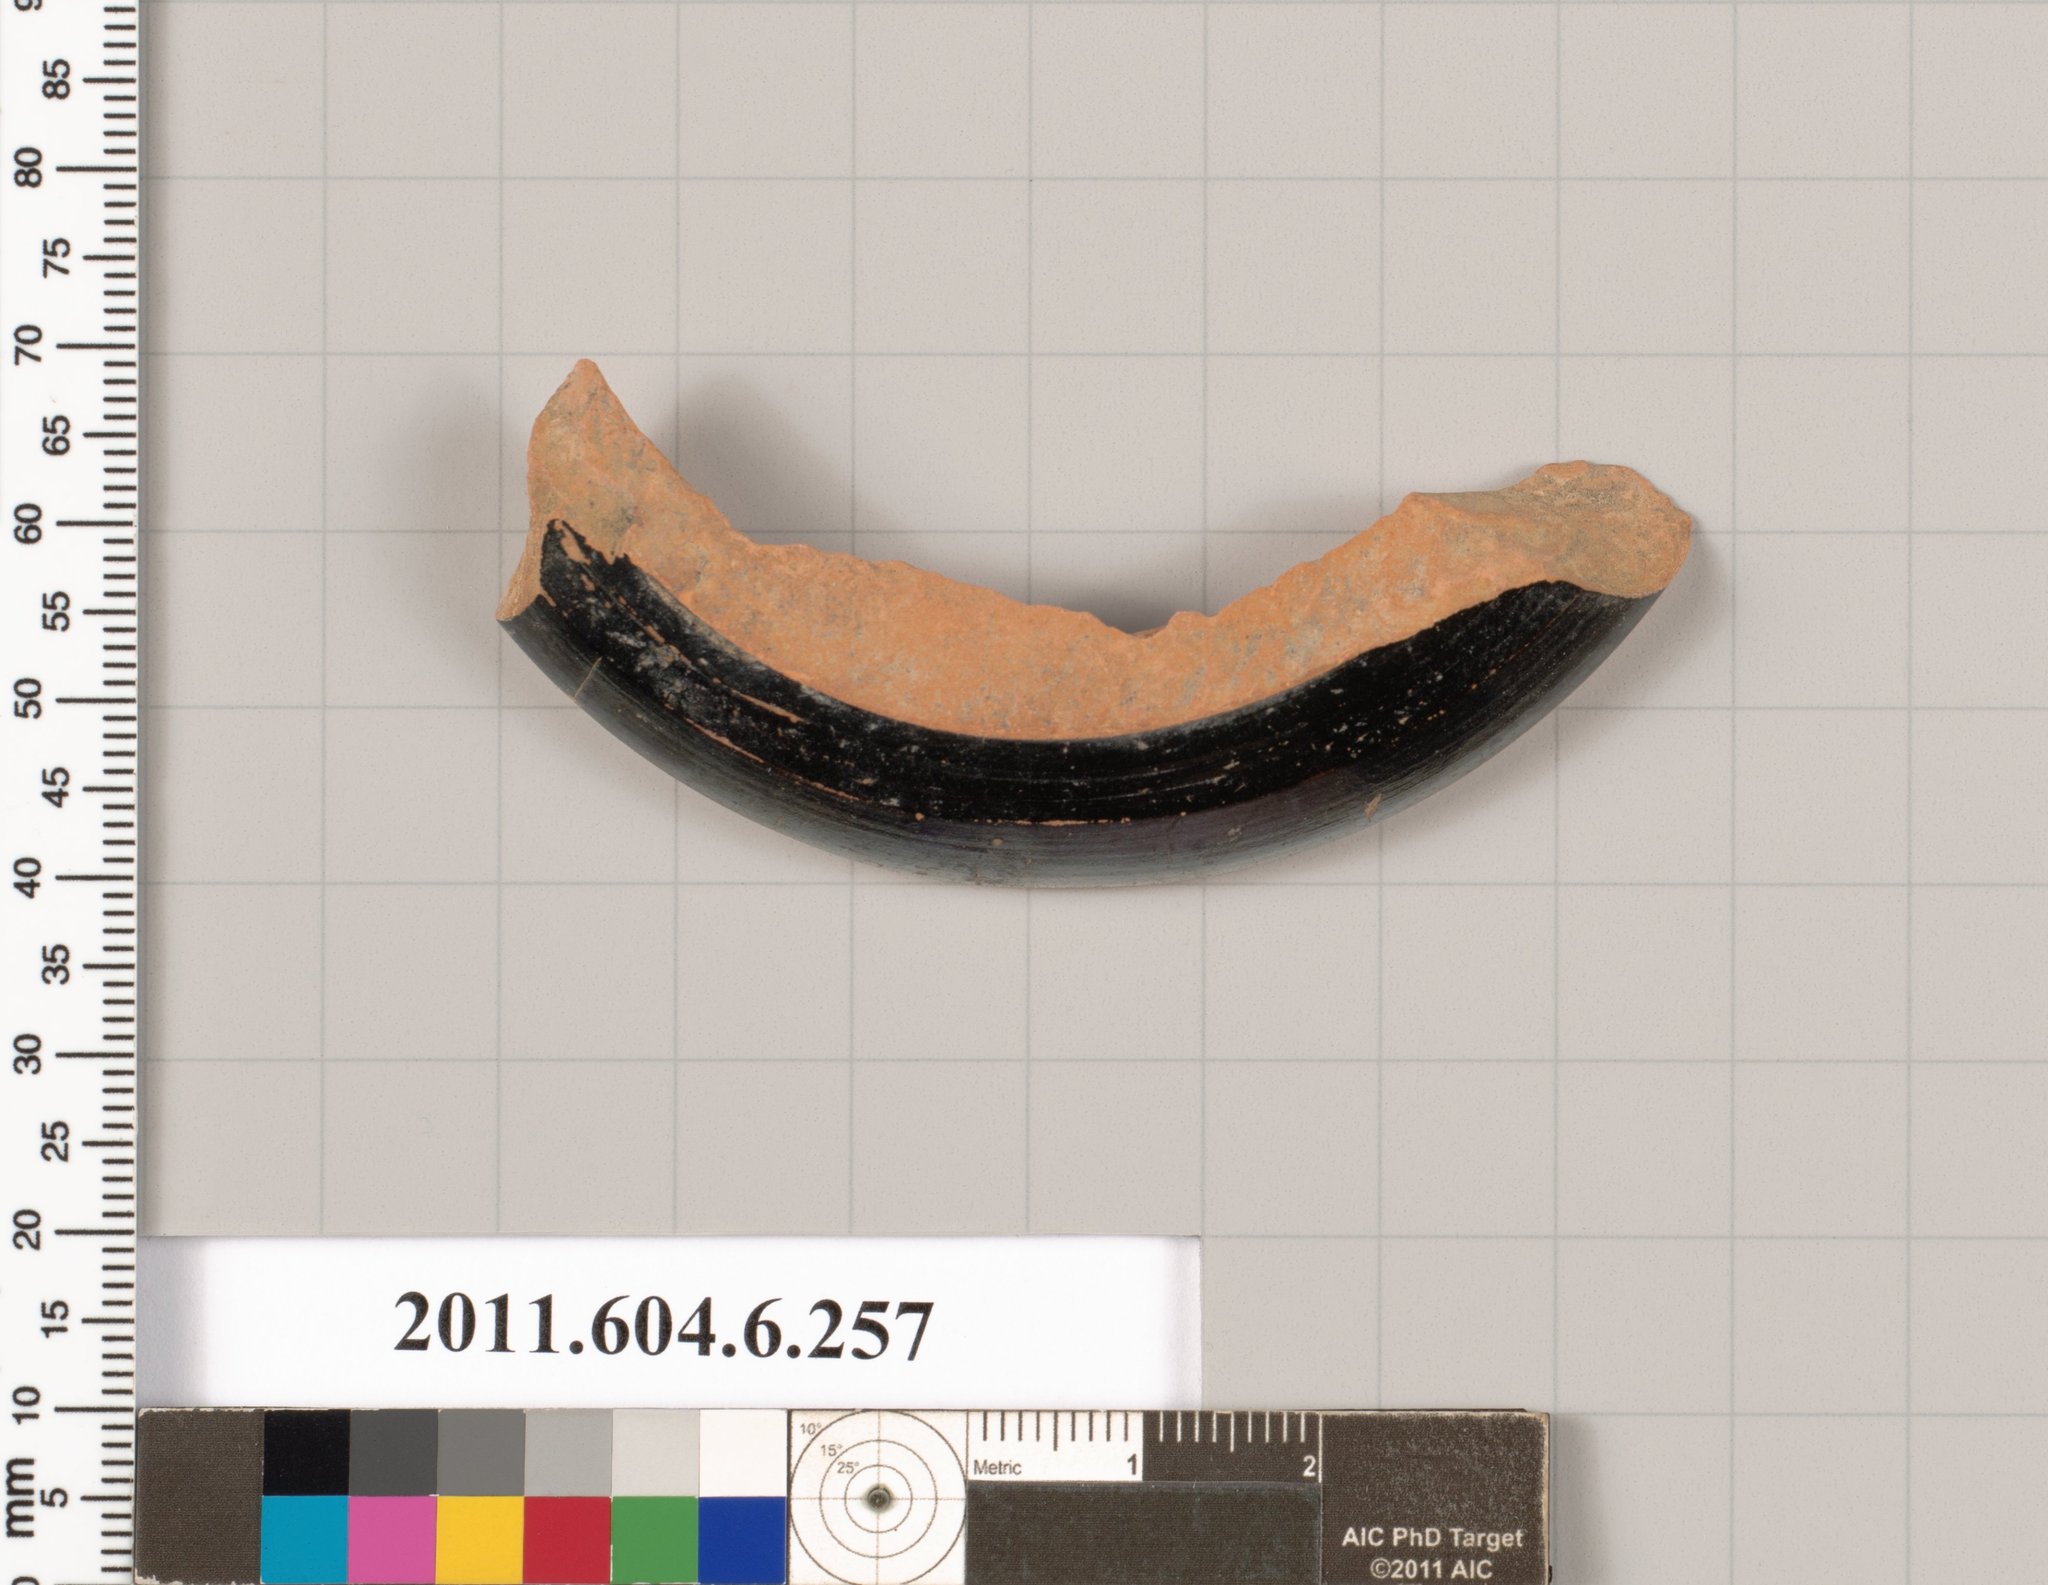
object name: undetermined shape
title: Terracotta fragment of an undetermined shape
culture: greek, attic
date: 600-401 BCE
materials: terracotta